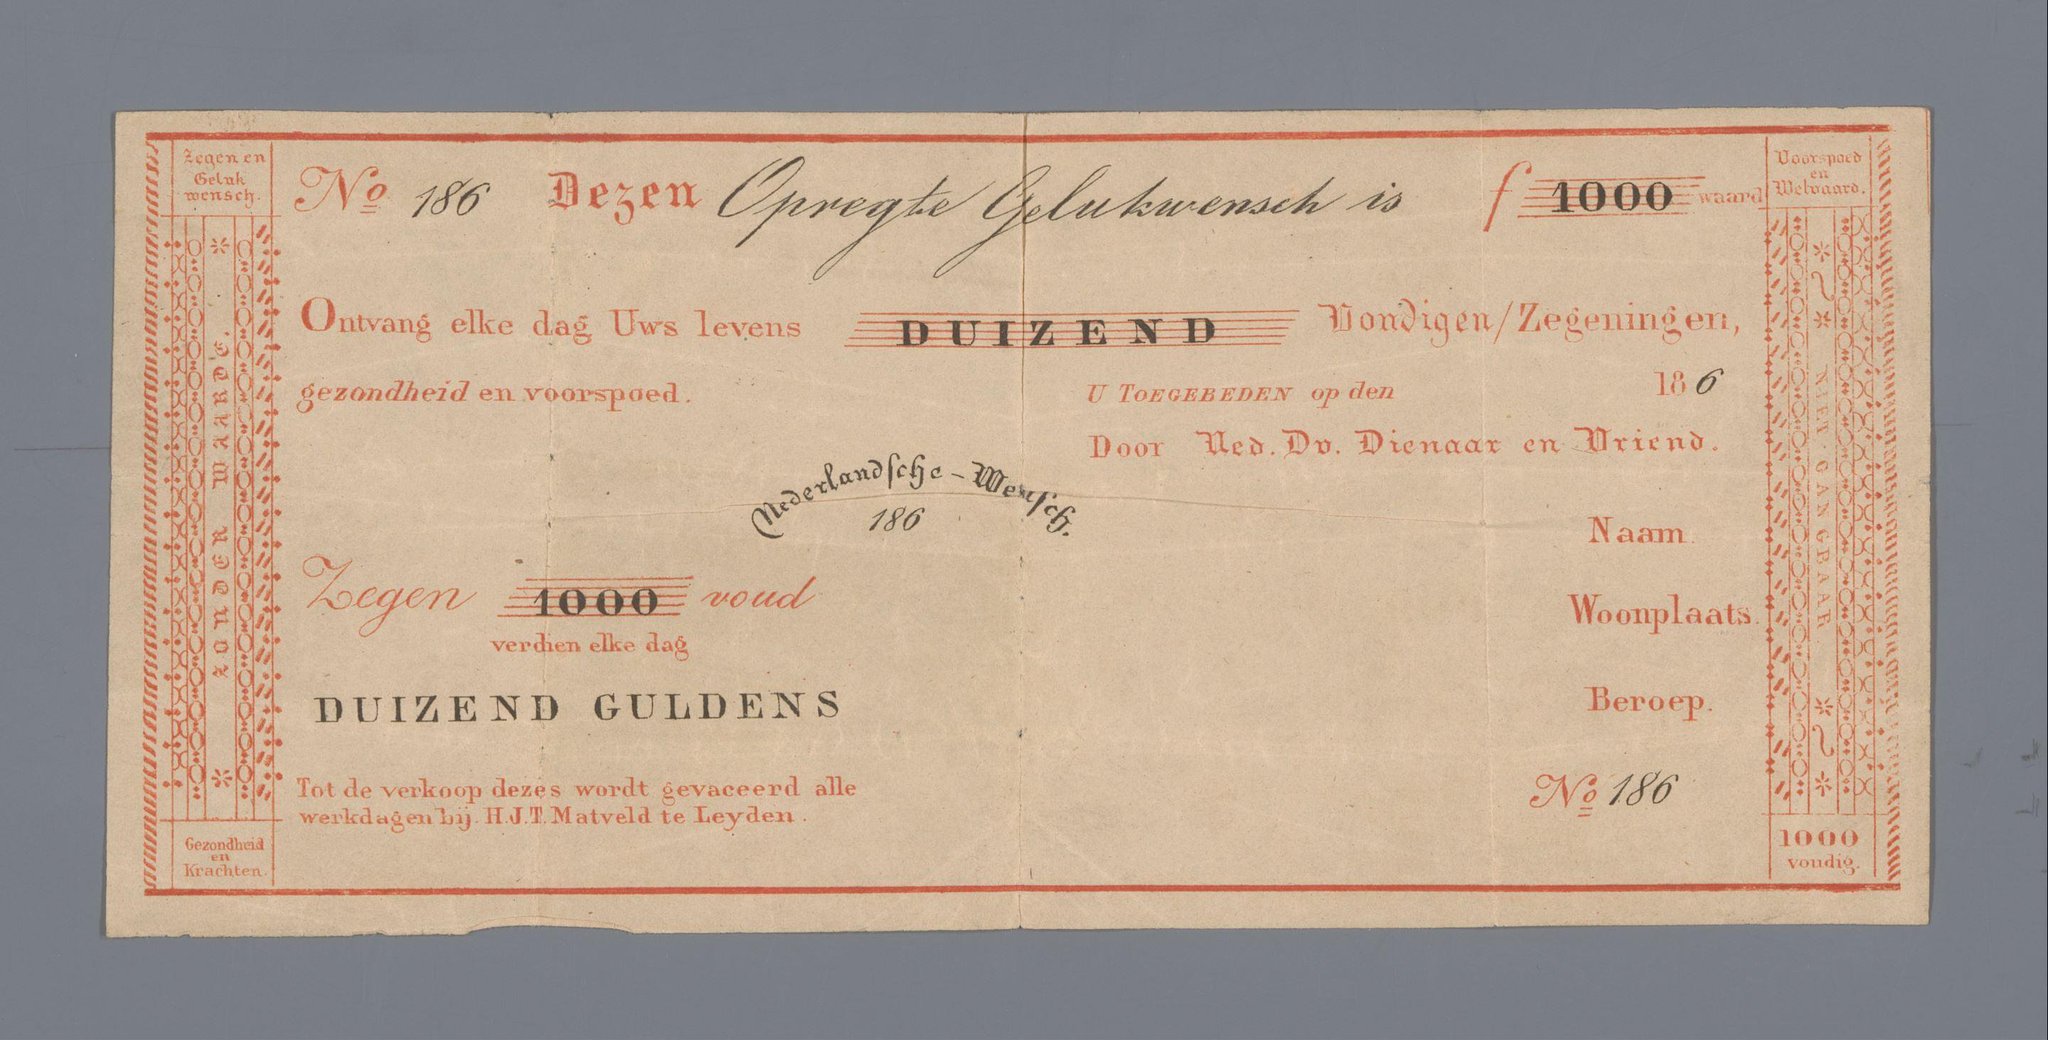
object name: waardepapier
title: Namaak-bankbiljet van 1000 gulden met no. 186, bedoeld als duizendvoudige gelukwens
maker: h.j.t. matveld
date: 1860-1869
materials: paper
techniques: printing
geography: leiden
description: Eenzijdig biljet: opschrift in rood en zwart; links en rechts: strook met versiering en opschriften.